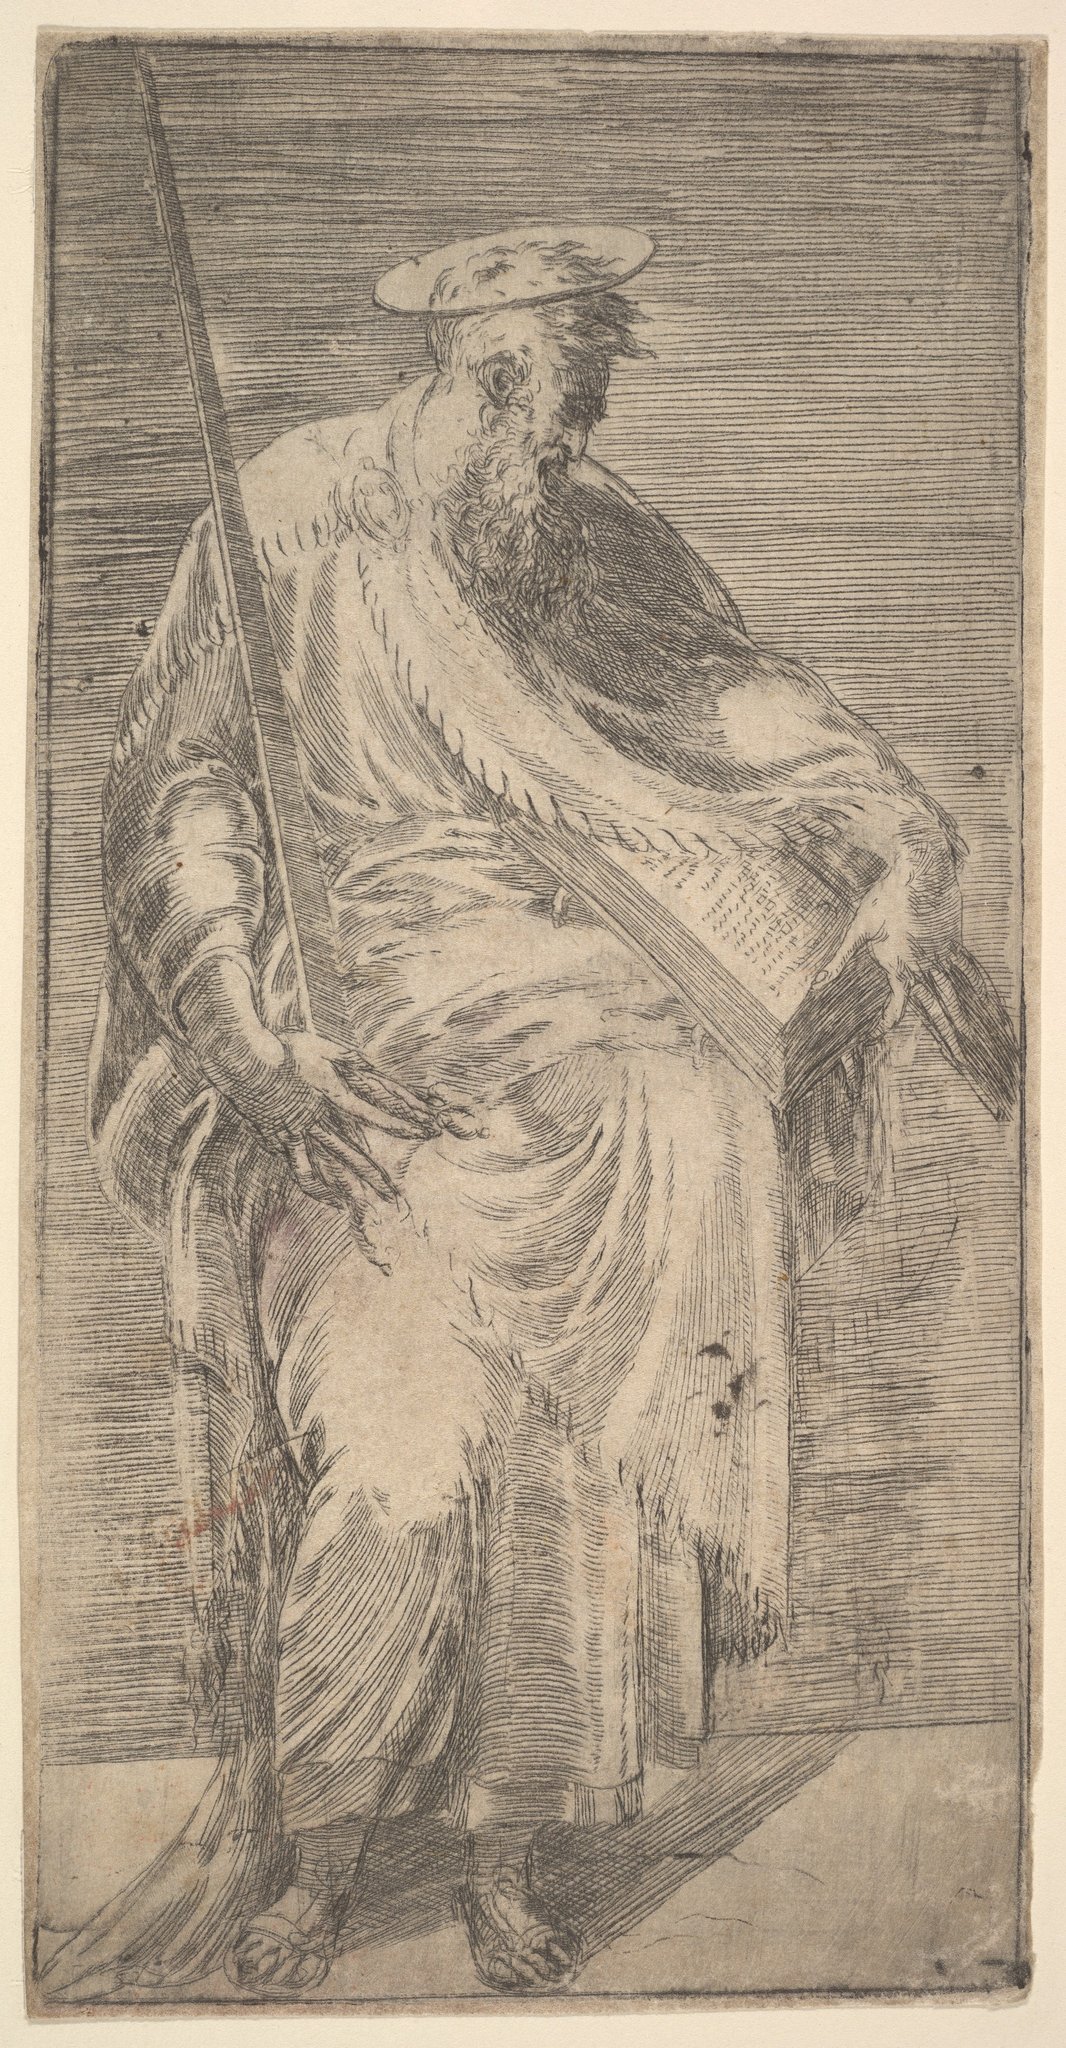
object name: print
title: Saint Paul holding a sword and a book, from Christ and the Apostles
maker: andrea schiavone (andrea meldola)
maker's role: artist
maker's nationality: italian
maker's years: 1510-1563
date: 1540-1563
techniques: etching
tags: books,swords,saint paul